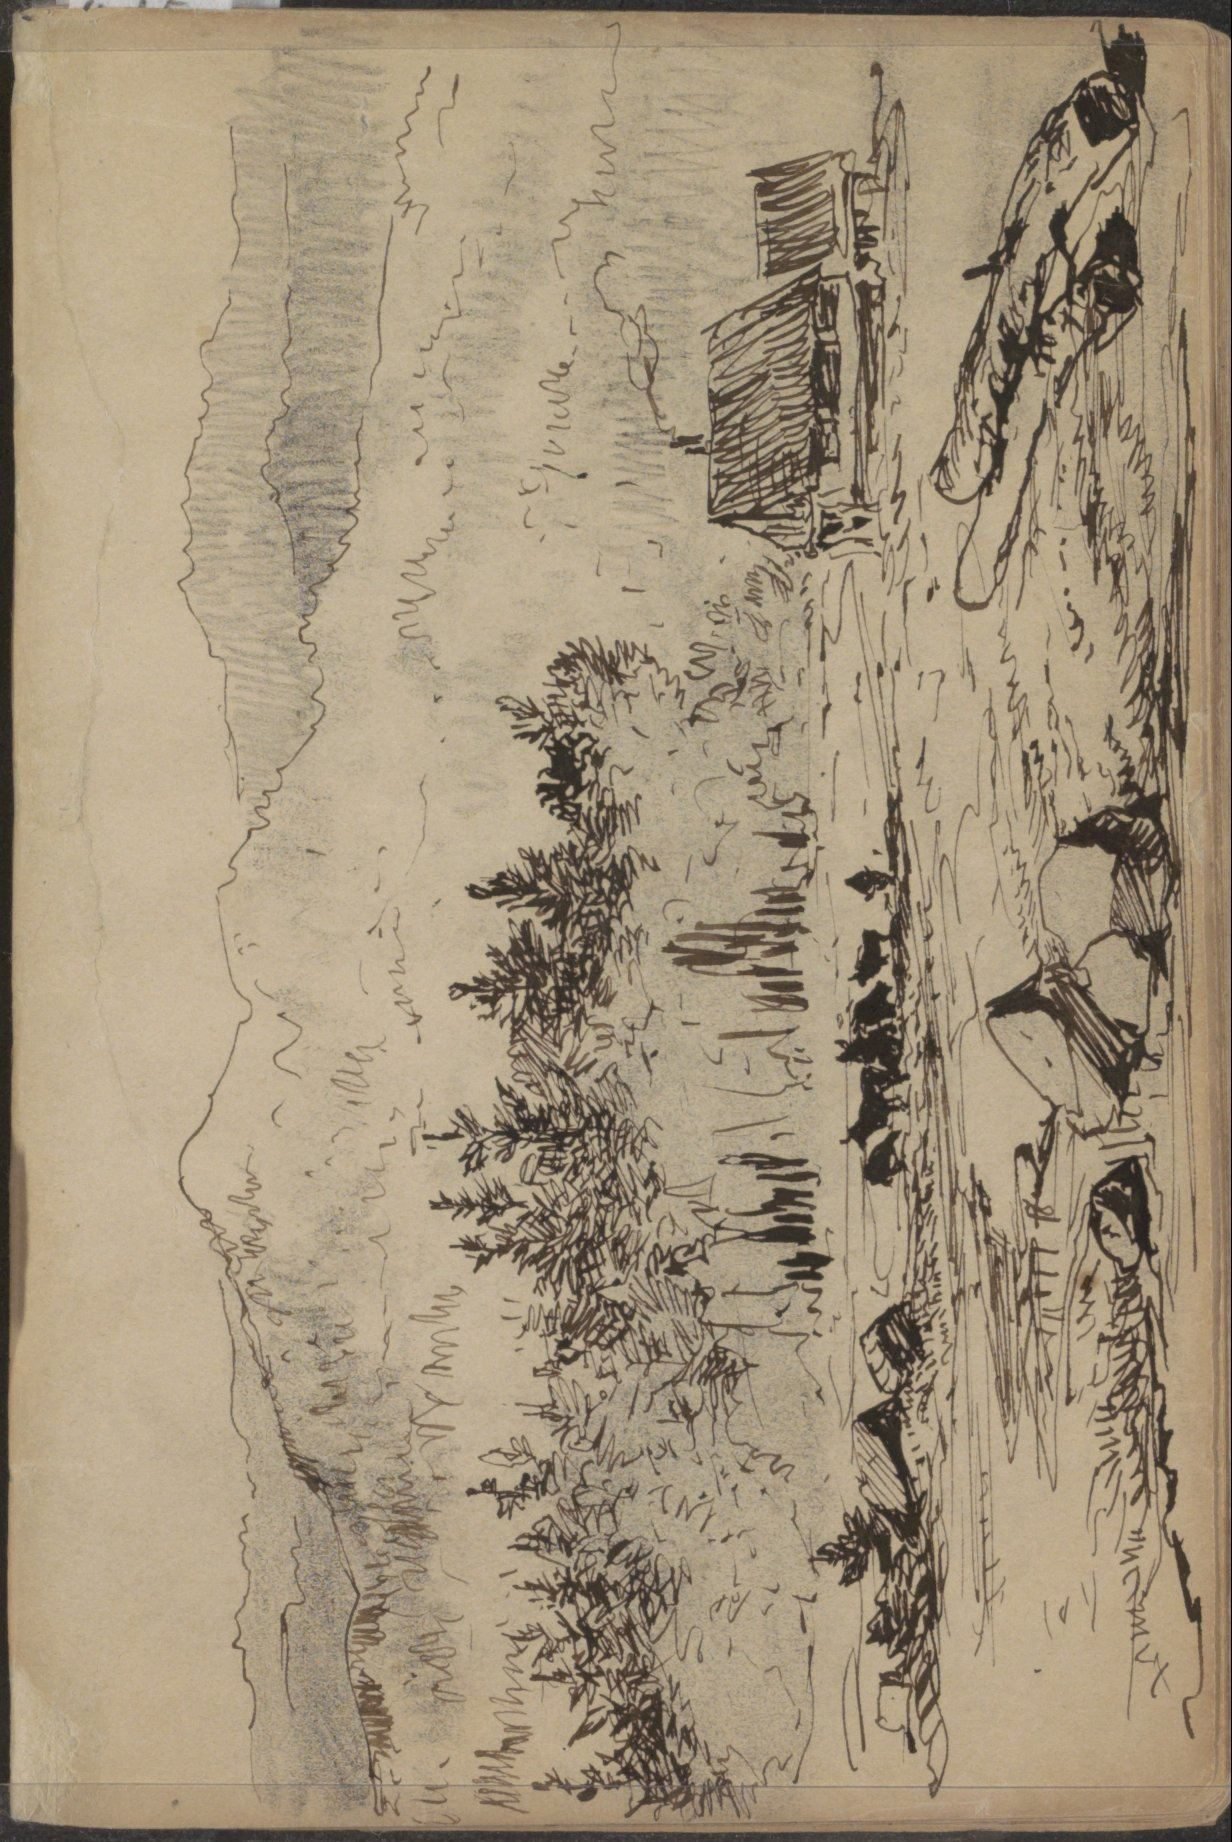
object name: sketchbook leaf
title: Berglandschap met vee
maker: johannes tavenraat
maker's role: draughtsman, painter, print maker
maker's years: 1809-1881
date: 1858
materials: ink, paper, pencil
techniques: pen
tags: city-view, and landscape with man-made constructions, cattle, mountains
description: Blad 3 recto uit een schetsboek met 44 bladen.